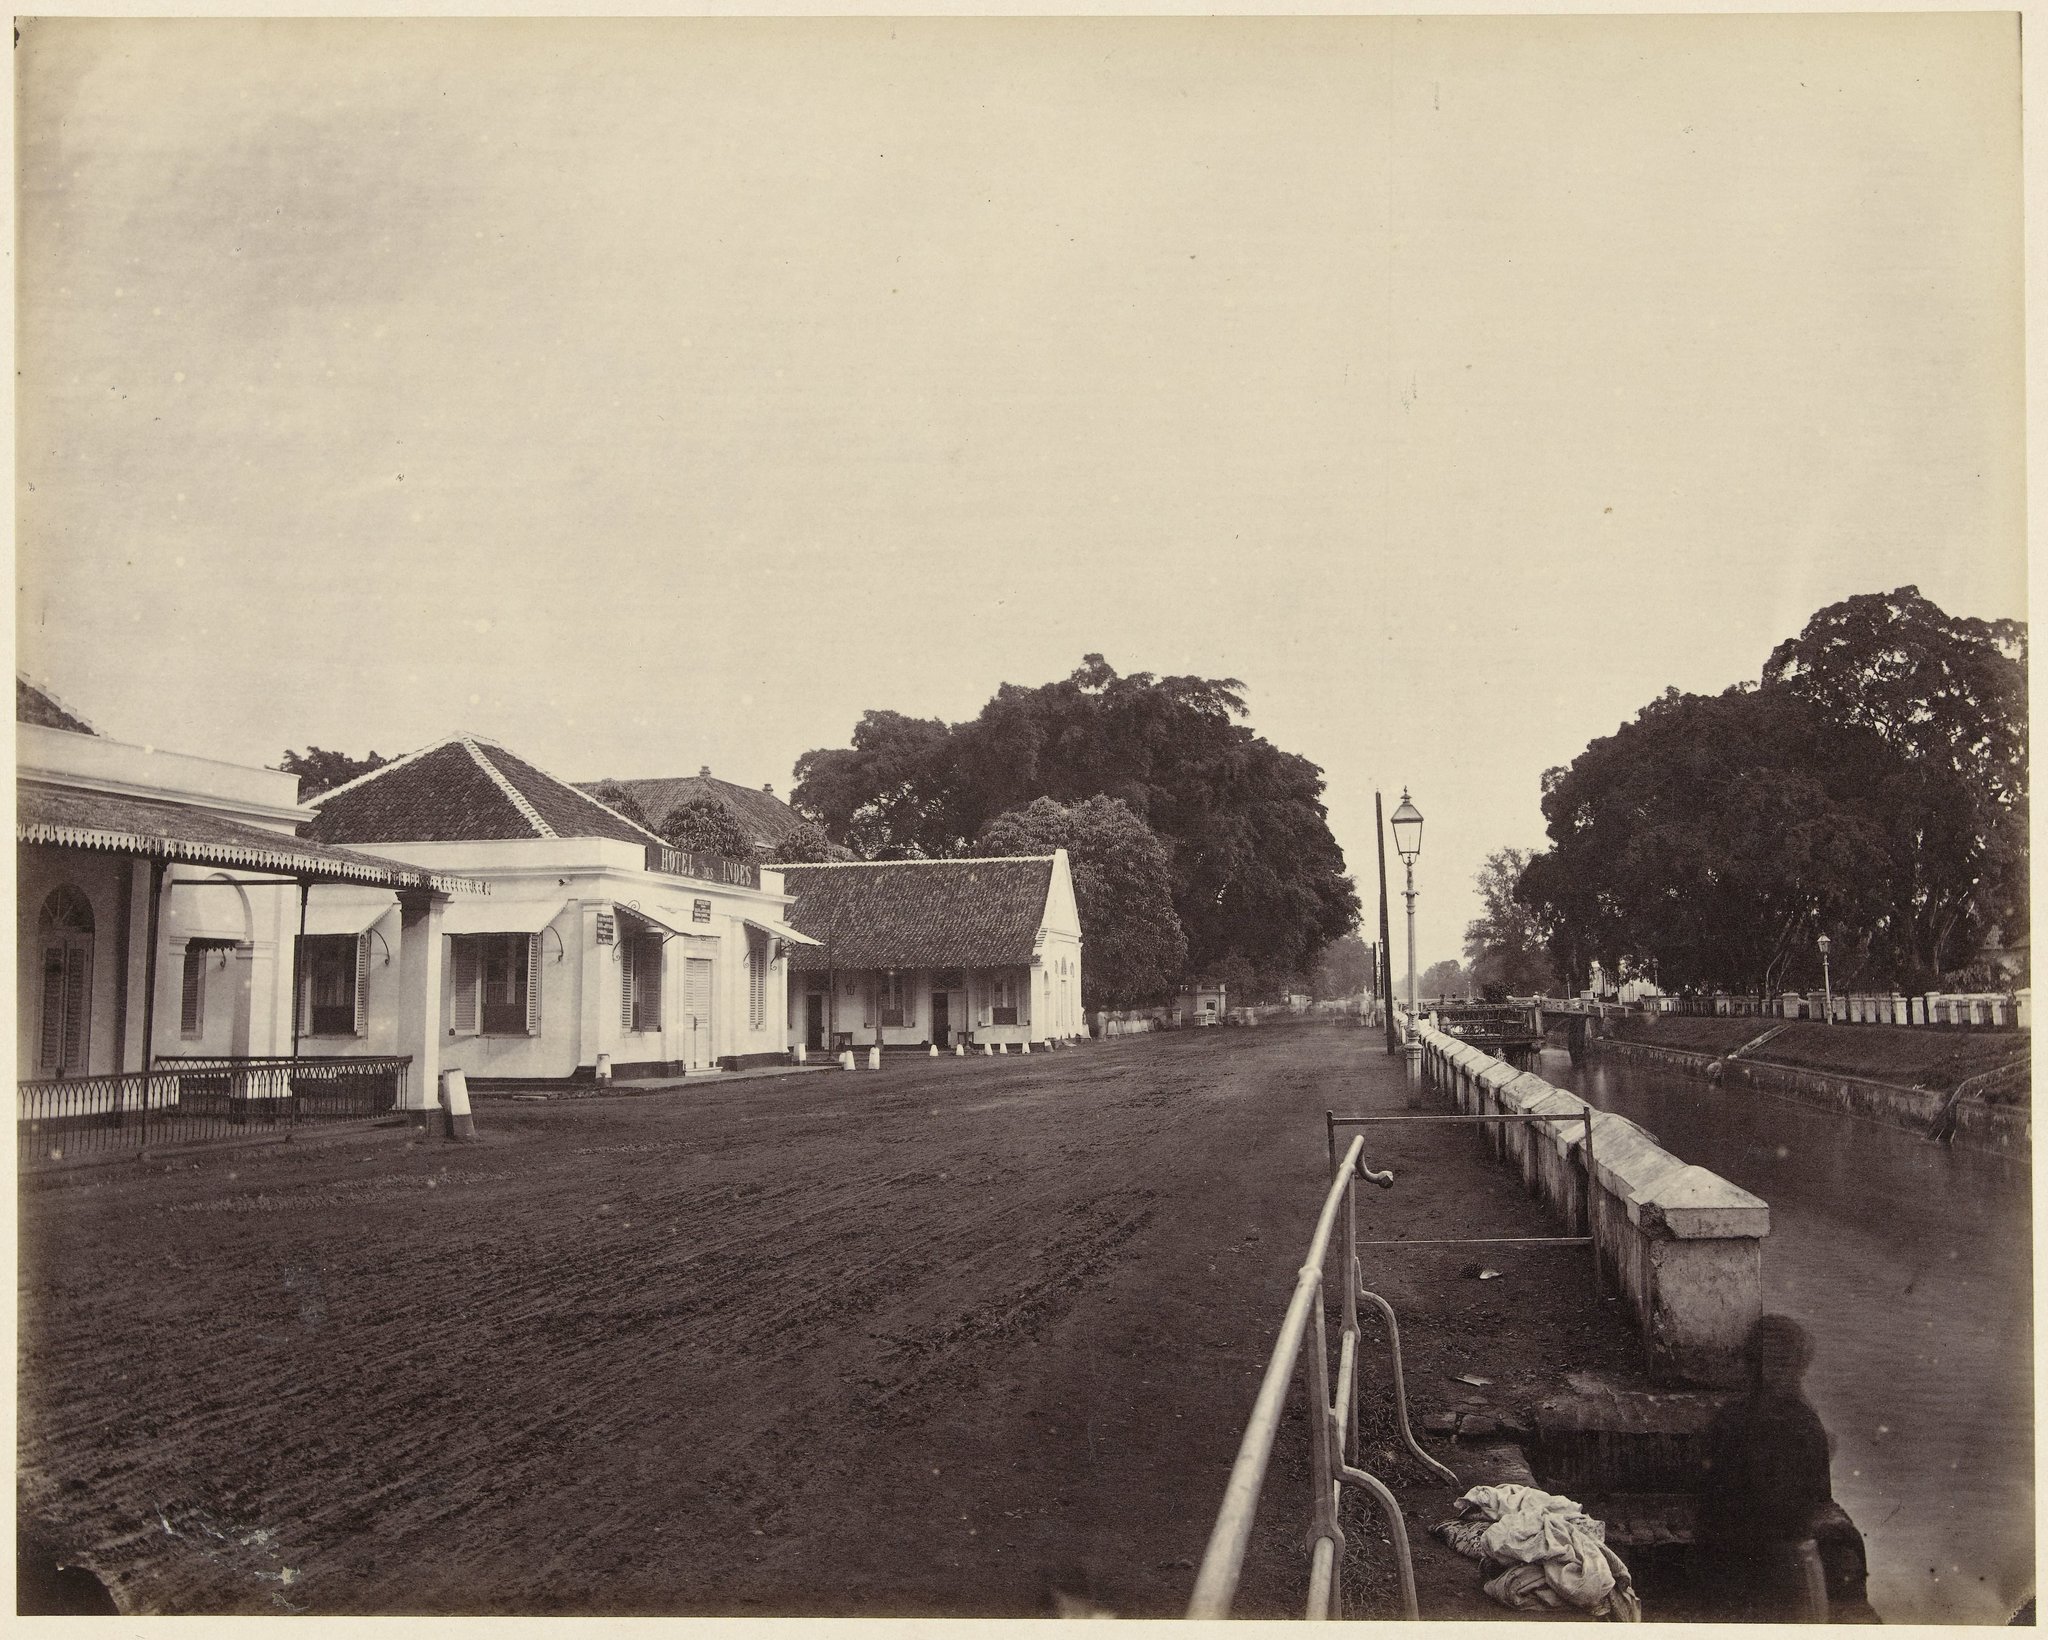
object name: photograph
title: Hotel des Indes aan de Molenvliet in Batavia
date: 1857-1863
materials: cardboard, paper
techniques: albumen print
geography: java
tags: canals, waters (in city), hotel, hostelry, inn